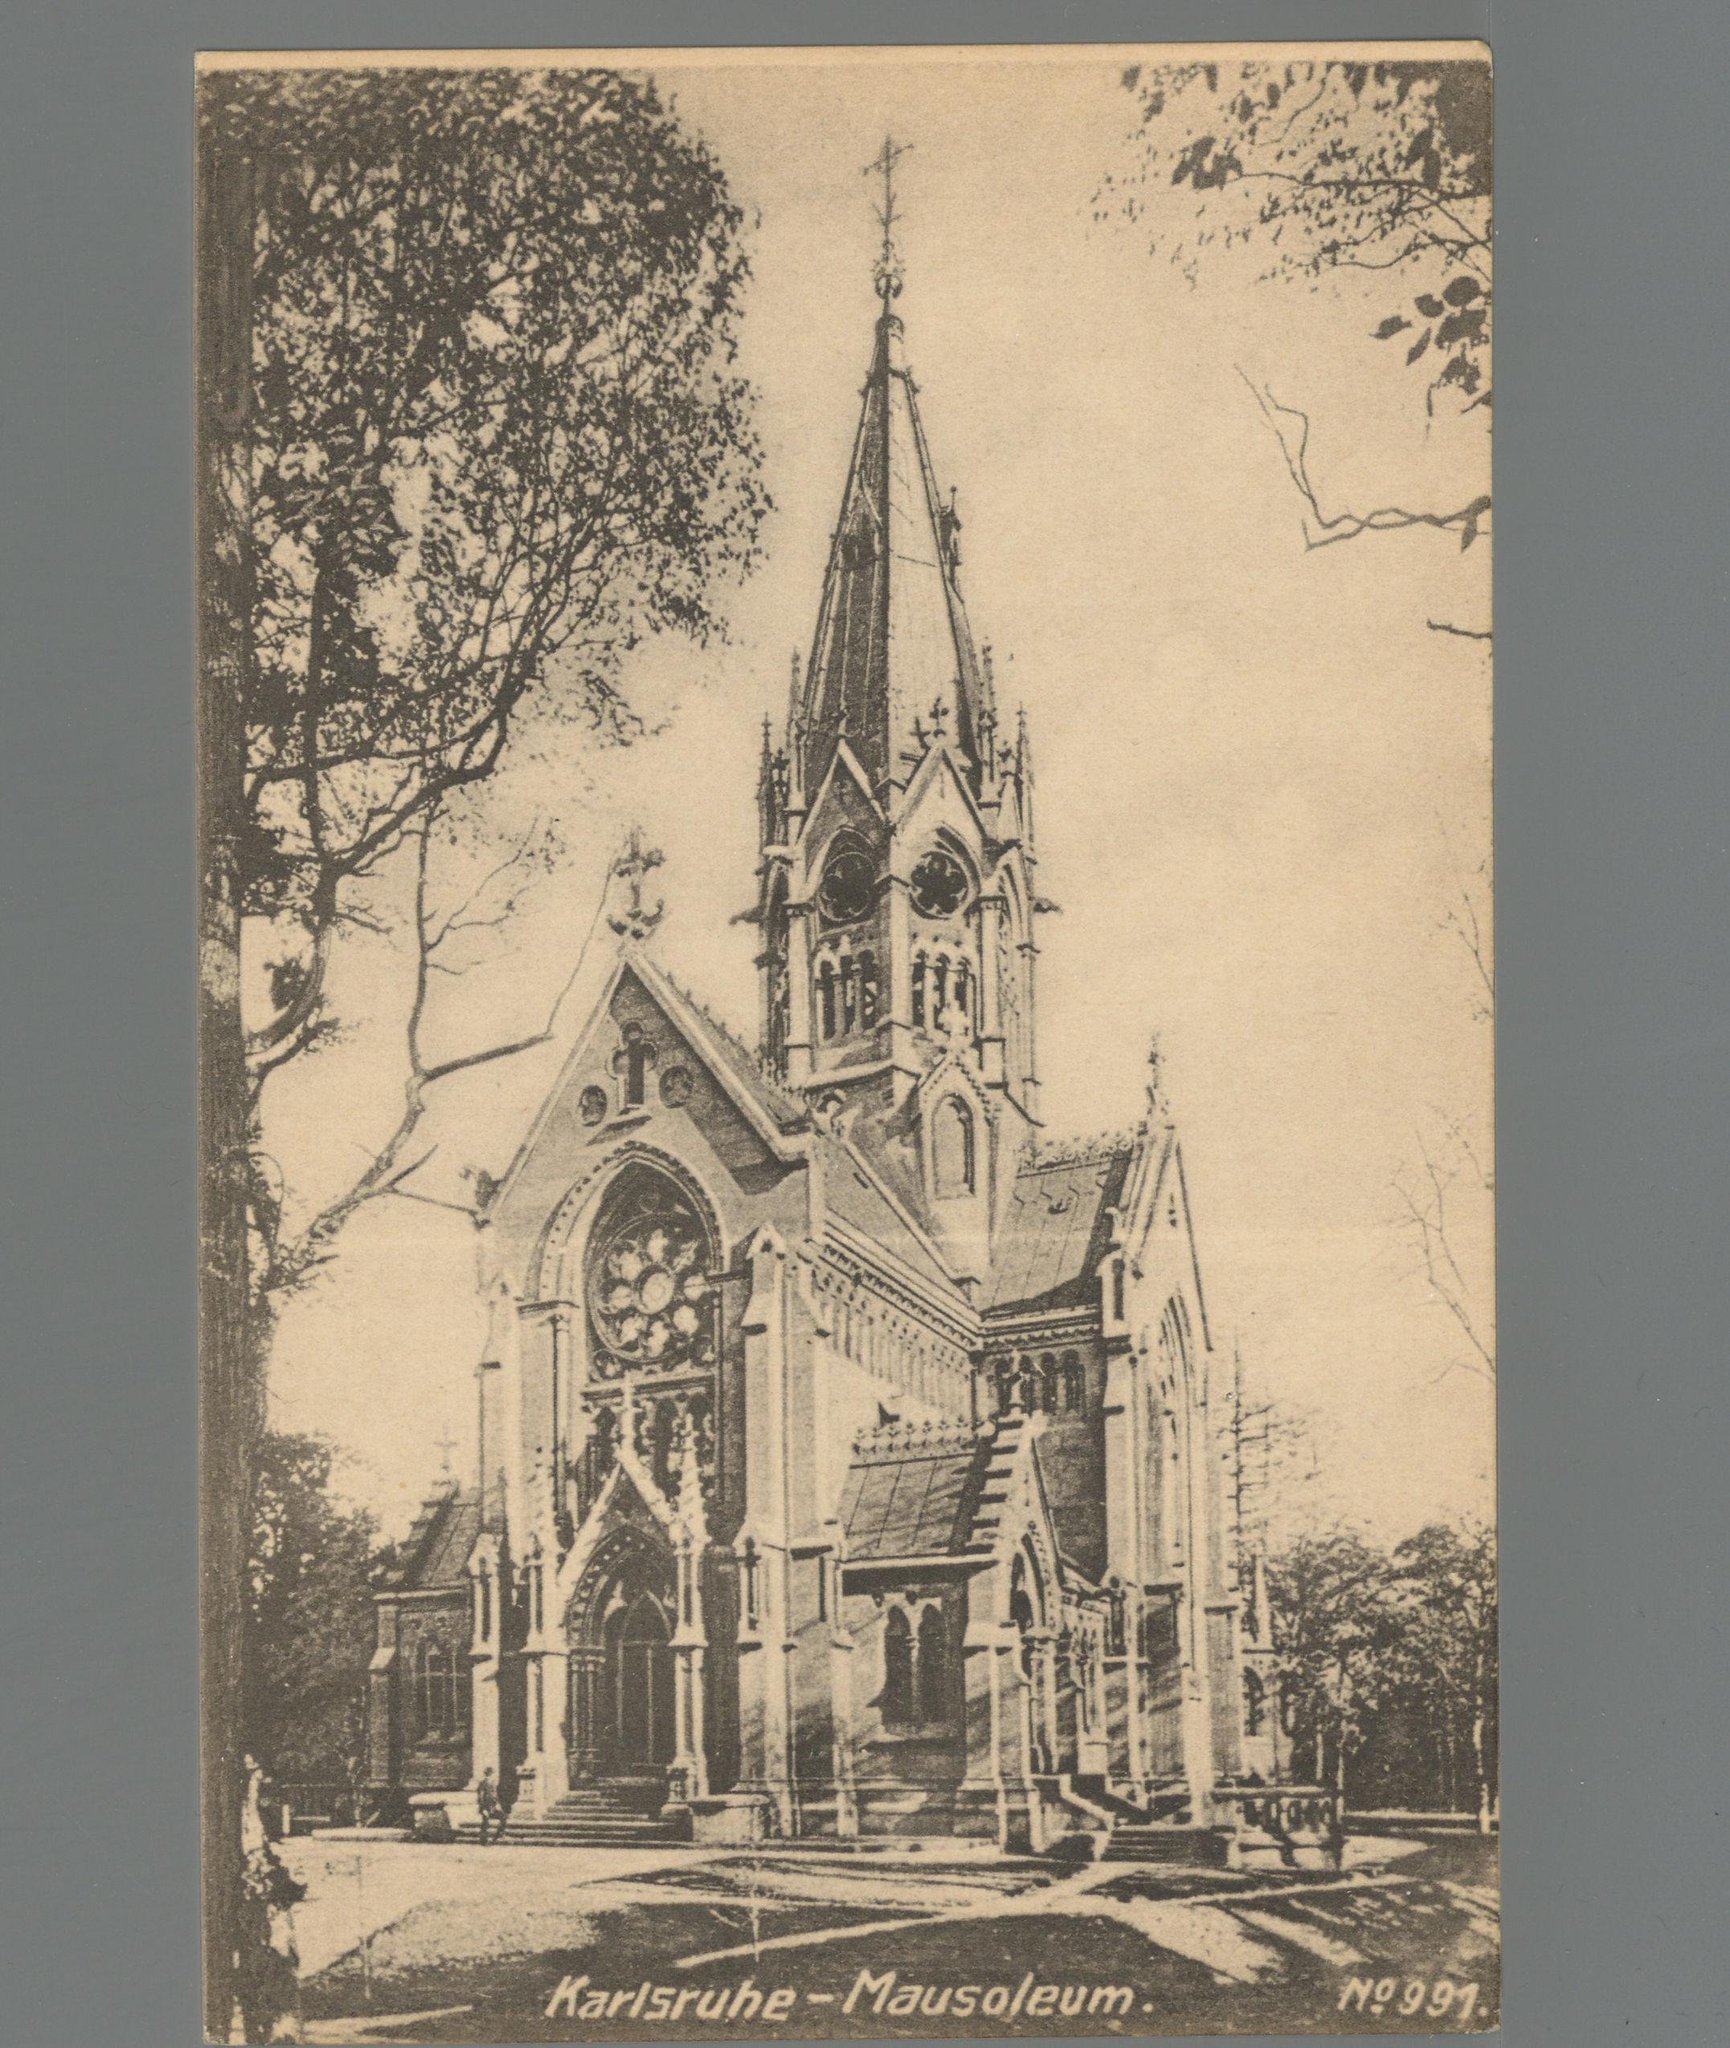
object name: reproduction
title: Karlsruhe - Mausoleum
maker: Anonymous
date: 1905-1930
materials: cardboard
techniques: photograph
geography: karlsruhe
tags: church (exterior), mausoleum